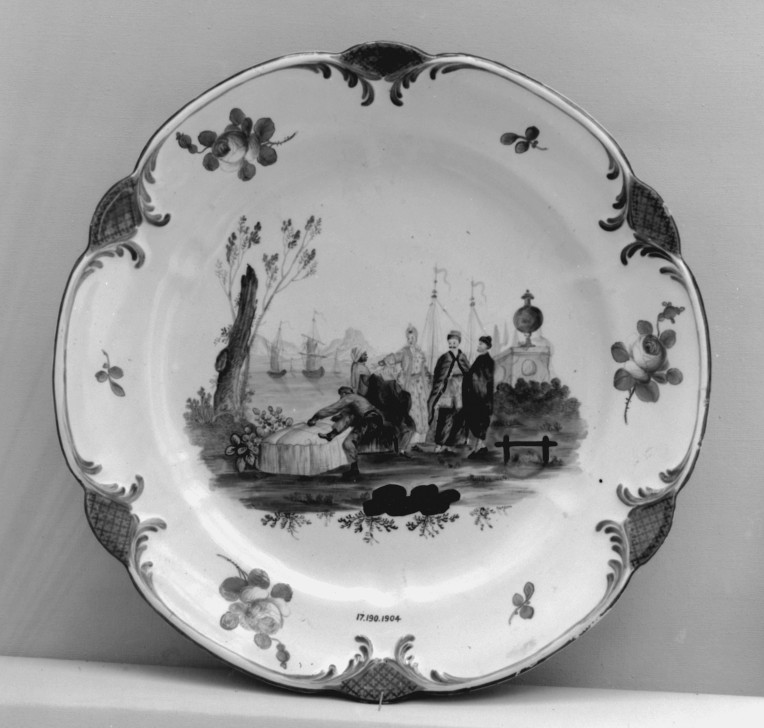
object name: plate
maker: levavasseur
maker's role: manufactory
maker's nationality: french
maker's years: 1715-1825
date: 1788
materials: faience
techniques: glazing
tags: men,women,flowers,trees